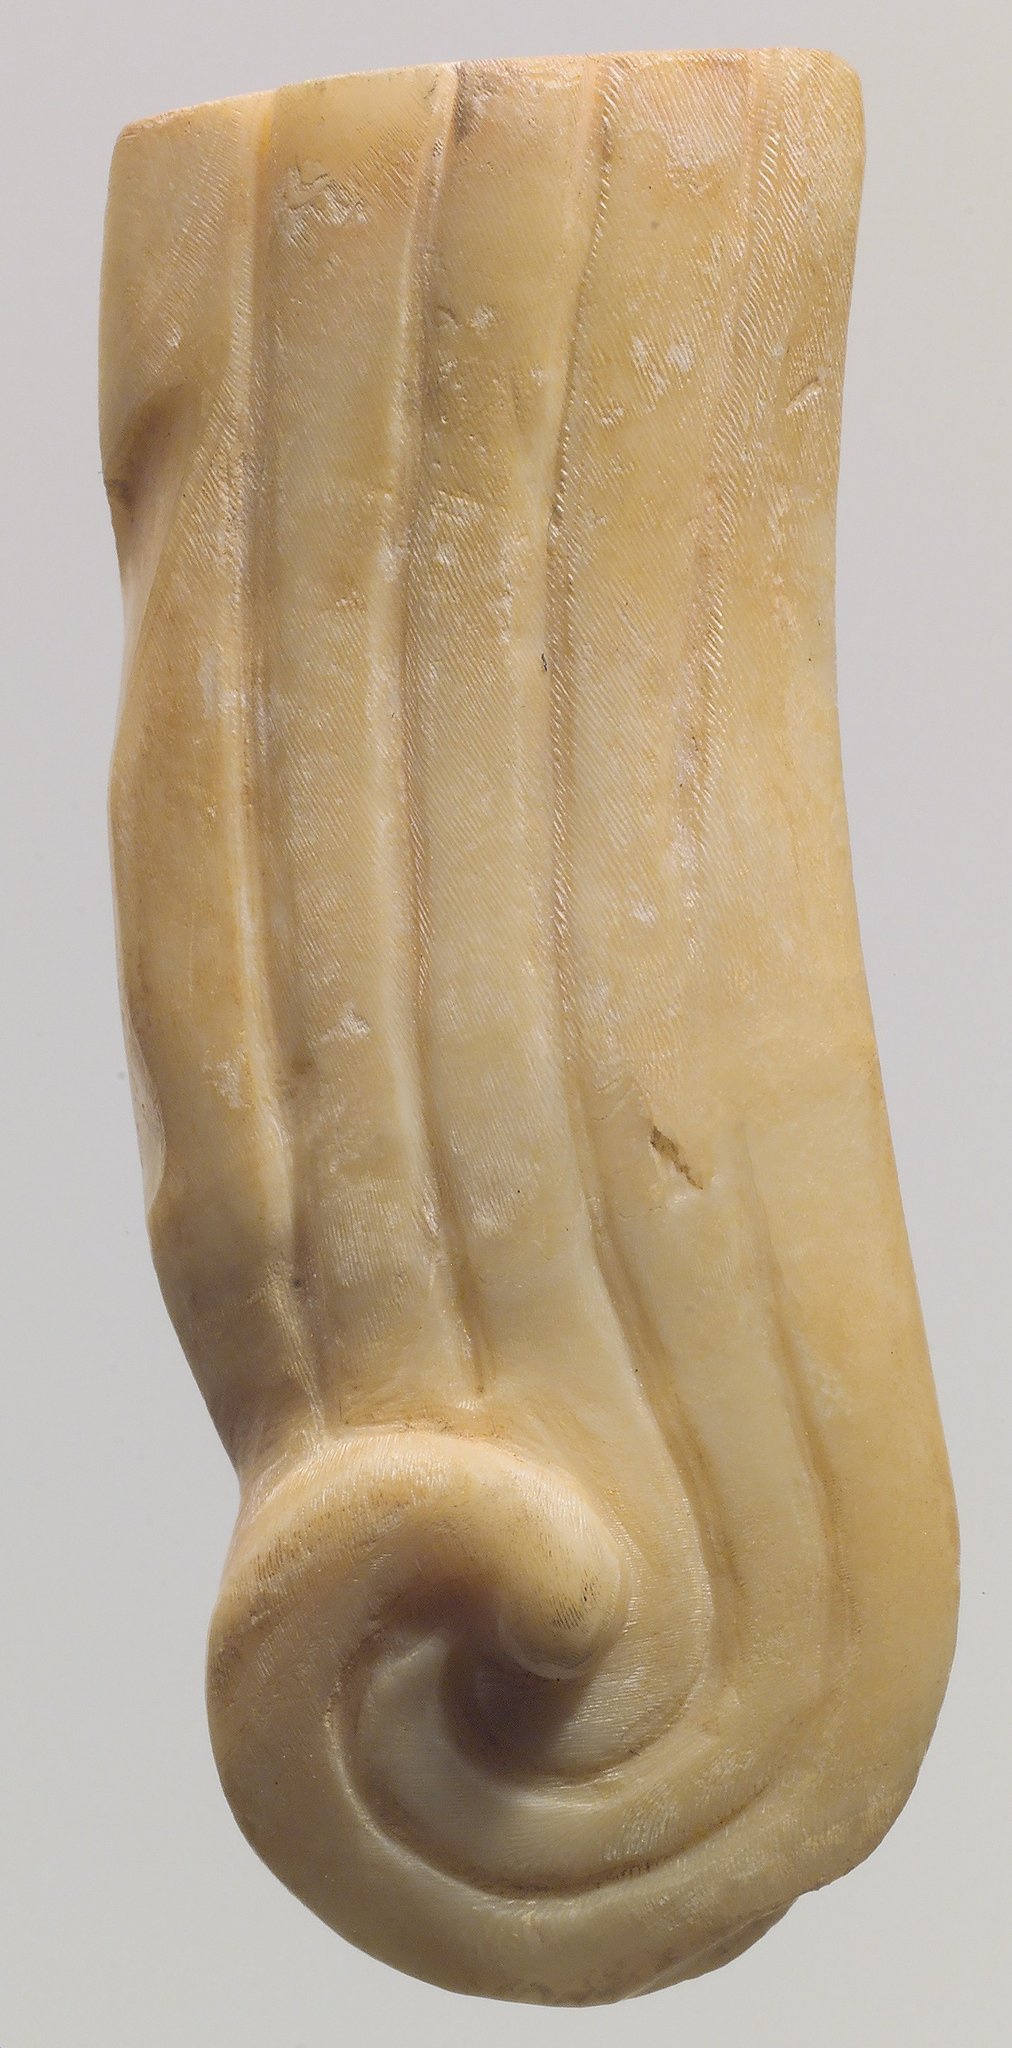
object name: ornament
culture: sumerian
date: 2900-2350 BCE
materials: shell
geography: mesopotamia